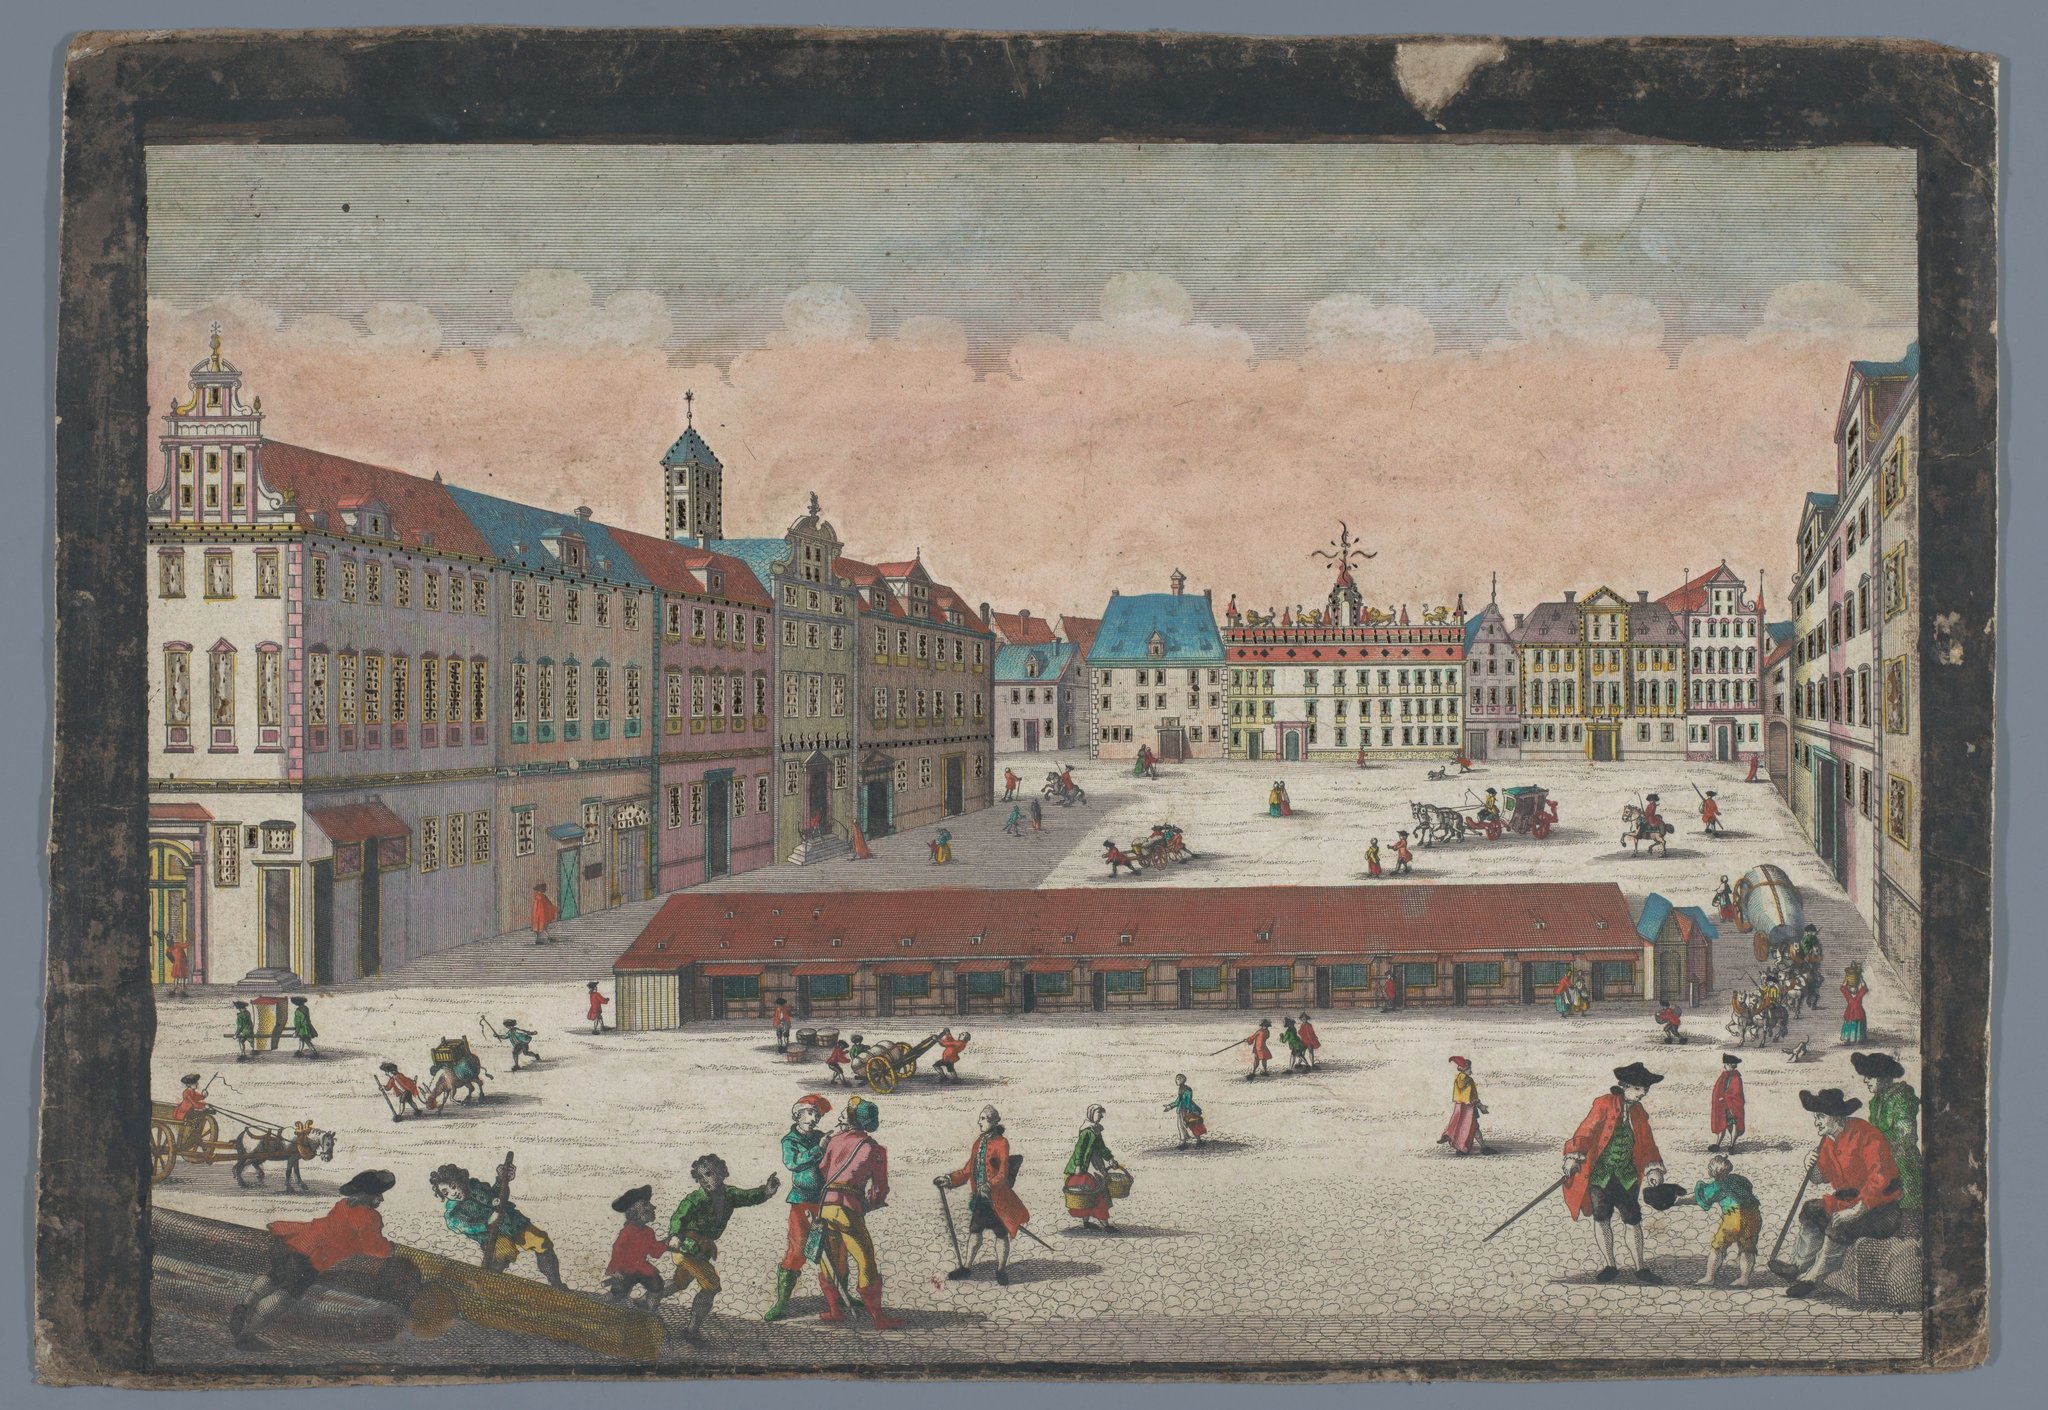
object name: print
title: Gezicht op het Zoutplein te Wroclaw gezien vanaf de zuidzijde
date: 1742-1801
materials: cardboard, paint, paper, watercolor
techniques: brush, cutting, etching, perforating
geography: augsburg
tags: square, place, circus, etc. (+ city(-scape) with figures, staffage)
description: Mogelijk rechtsboven genummerd geweest: 247. Mogelijk linksonder genummerd geweest: 60. De serie “Wroclaw”, met het nummer 60, bevat vier prenten met de nummers 244-247, waarvan dit mogelijk nummer 247 is.